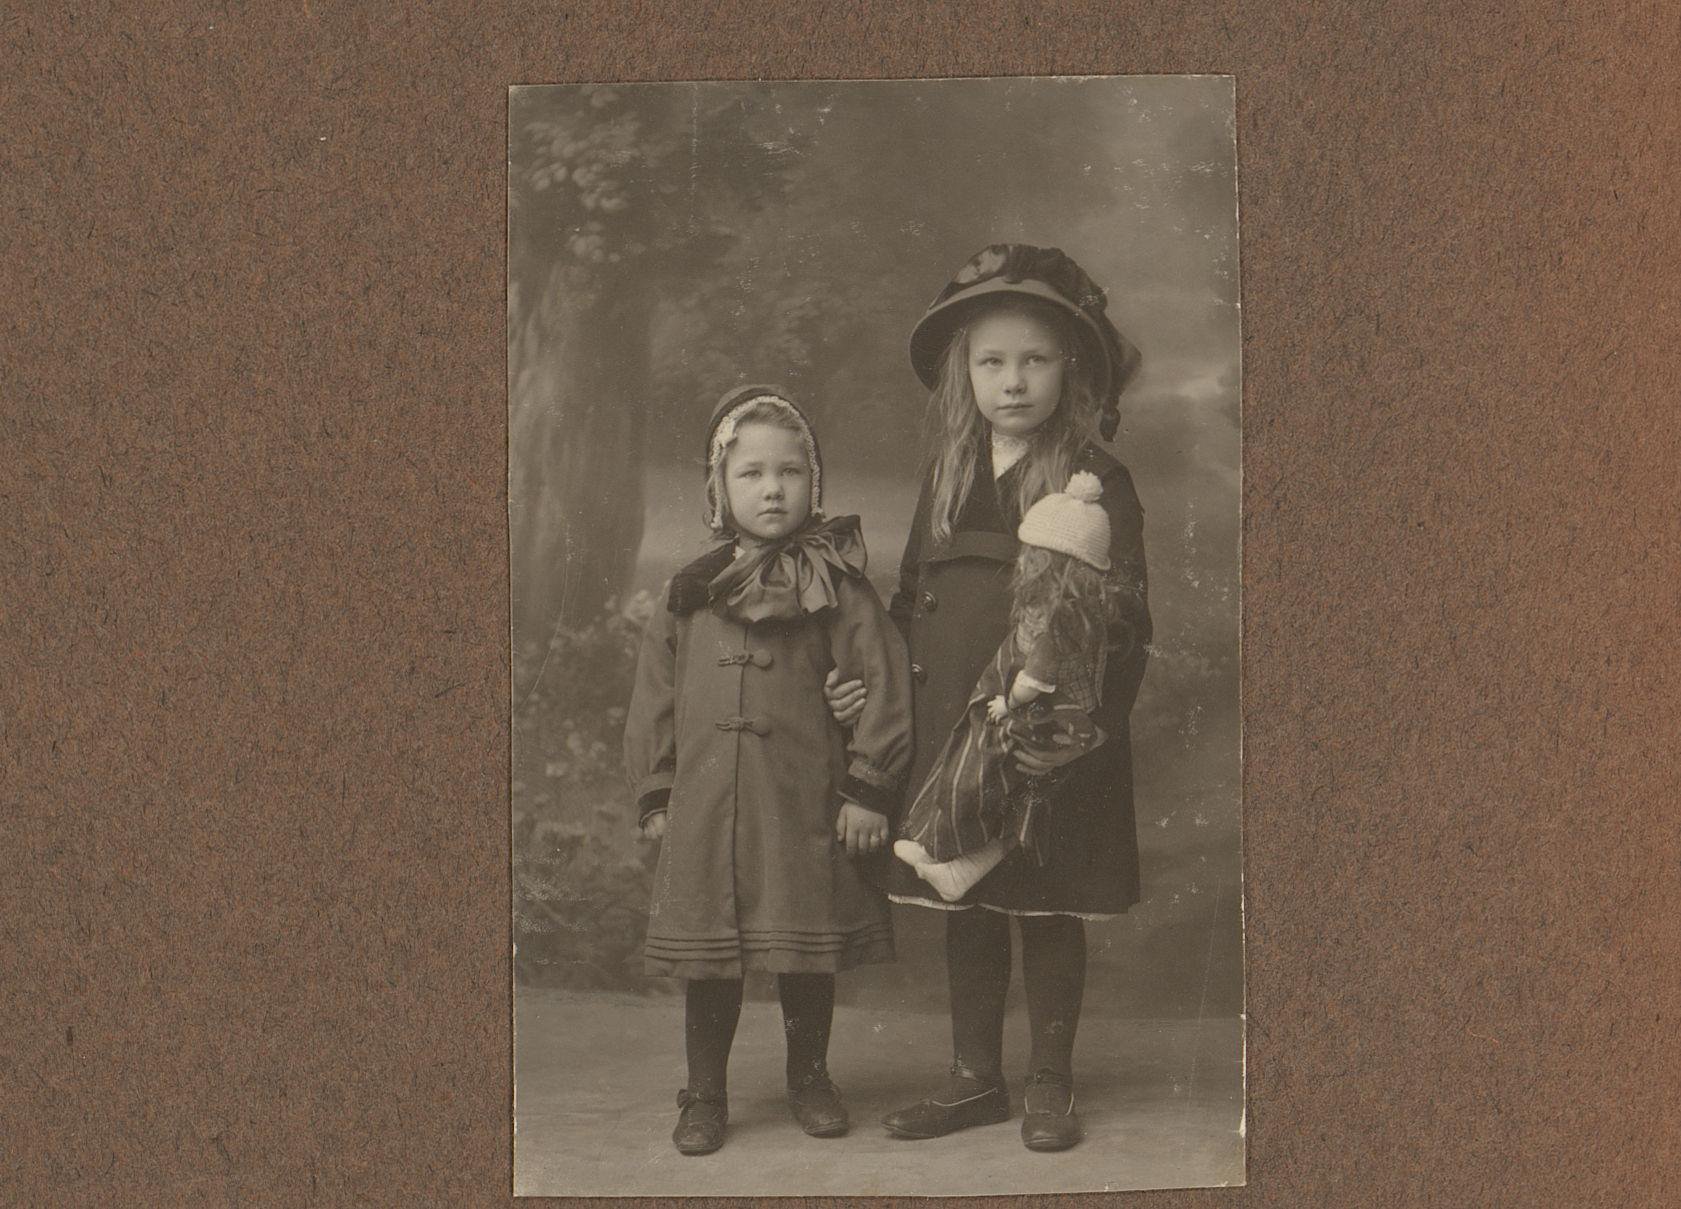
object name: photograph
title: De dochters van Alphons Diepenbrock: Thea en Joanna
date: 1908-1915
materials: photographic support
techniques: photography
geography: netherlands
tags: amsterdam, netherlands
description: Foto op bruin albumblad 45 van familiealbum van Alphons Diepenbrock.